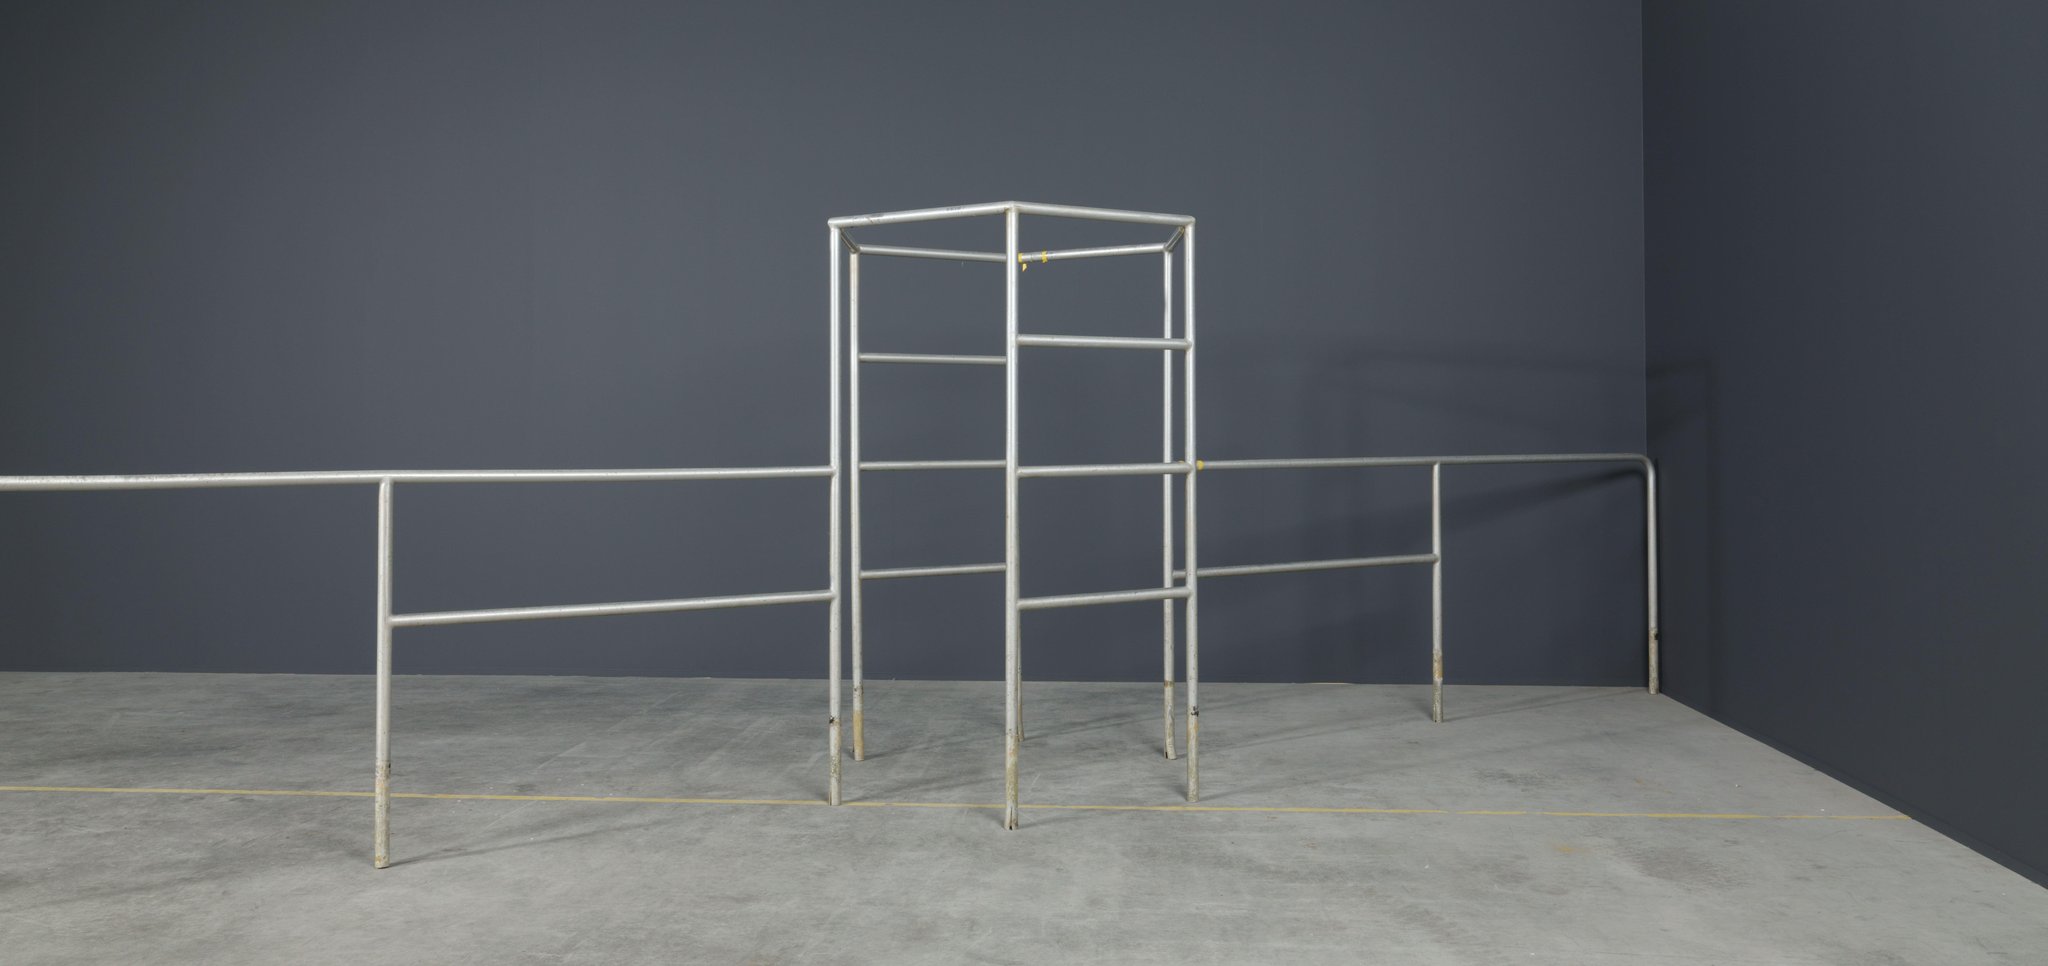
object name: speeltoestel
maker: aldo van eyck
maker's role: architect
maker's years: 1918-1999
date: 1962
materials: aluminum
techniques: welding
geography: netherlands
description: Speeltoestel opgebouwd uit aluminium buis. Drie zeshoekige klimtorens, die onderling verbonden zijn door een inrichting die dienst kan doen als duikelrek en brug.